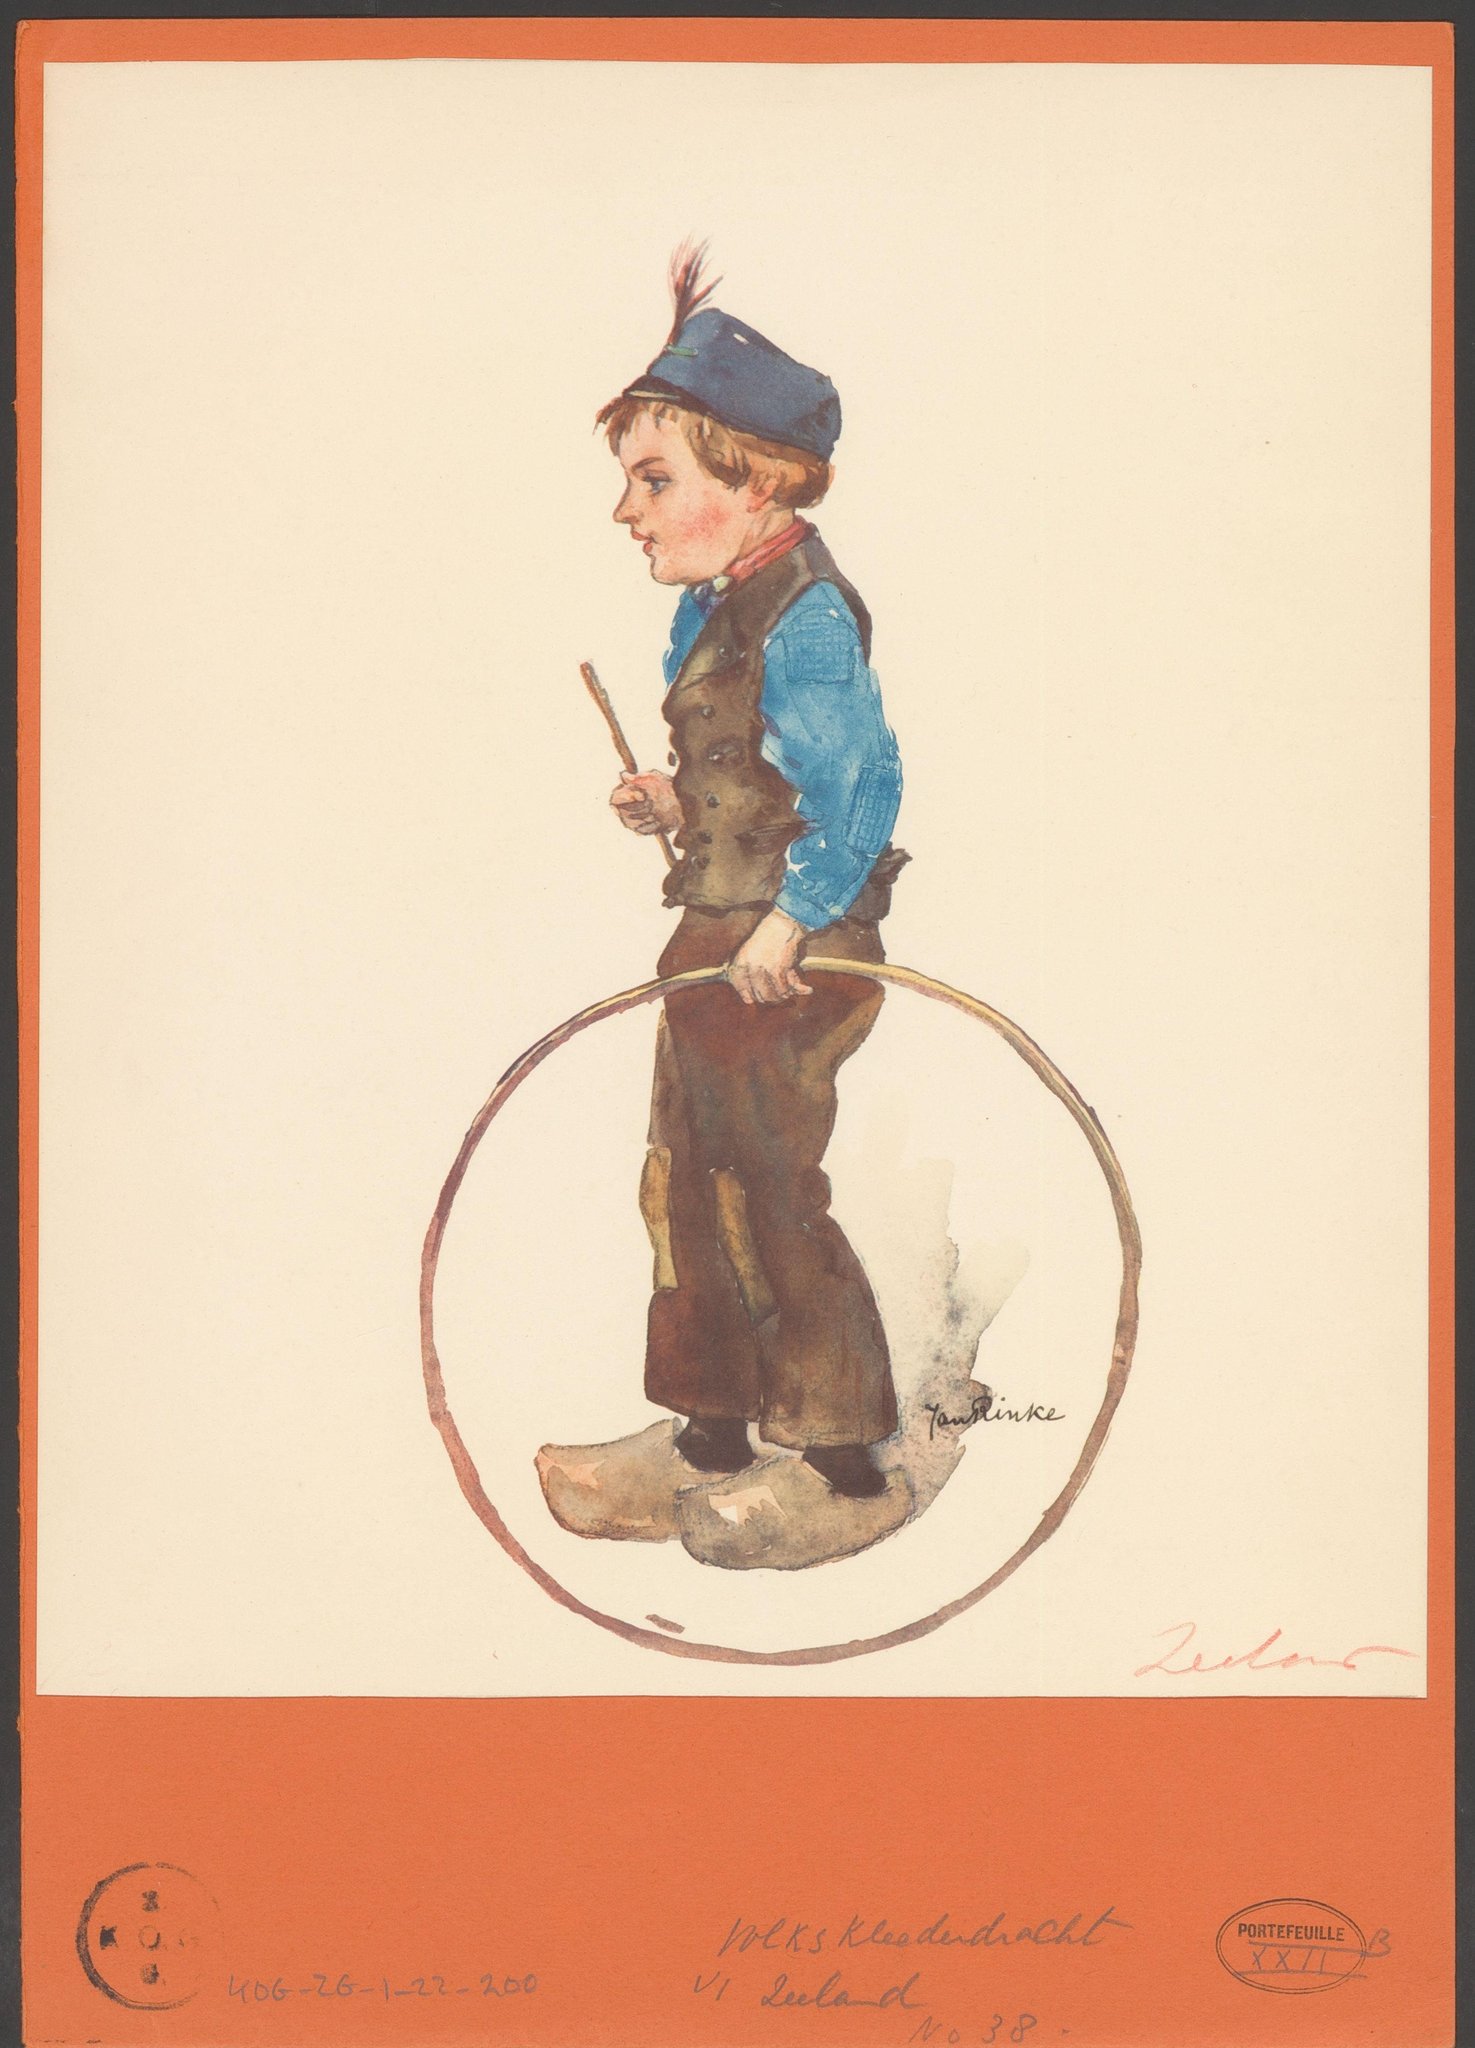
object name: photomechanical print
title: Jongen van Zeeland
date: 1920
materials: paper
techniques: photograph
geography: netherlands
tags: clothes, costume (+ children's clothes), (bowling a) hoop, folk costume, regional costume, zeeland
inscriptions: collector's mark: Lugt 1641, collector's mark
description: Boerenjongen in klederdracht van Walcheren, staande met een hoepel in de hand. Onderwerpsrubrieken binnen de Atlas Zeden en Gewoonten: De Kleeding, Volkskleederdracht, Zeeland.